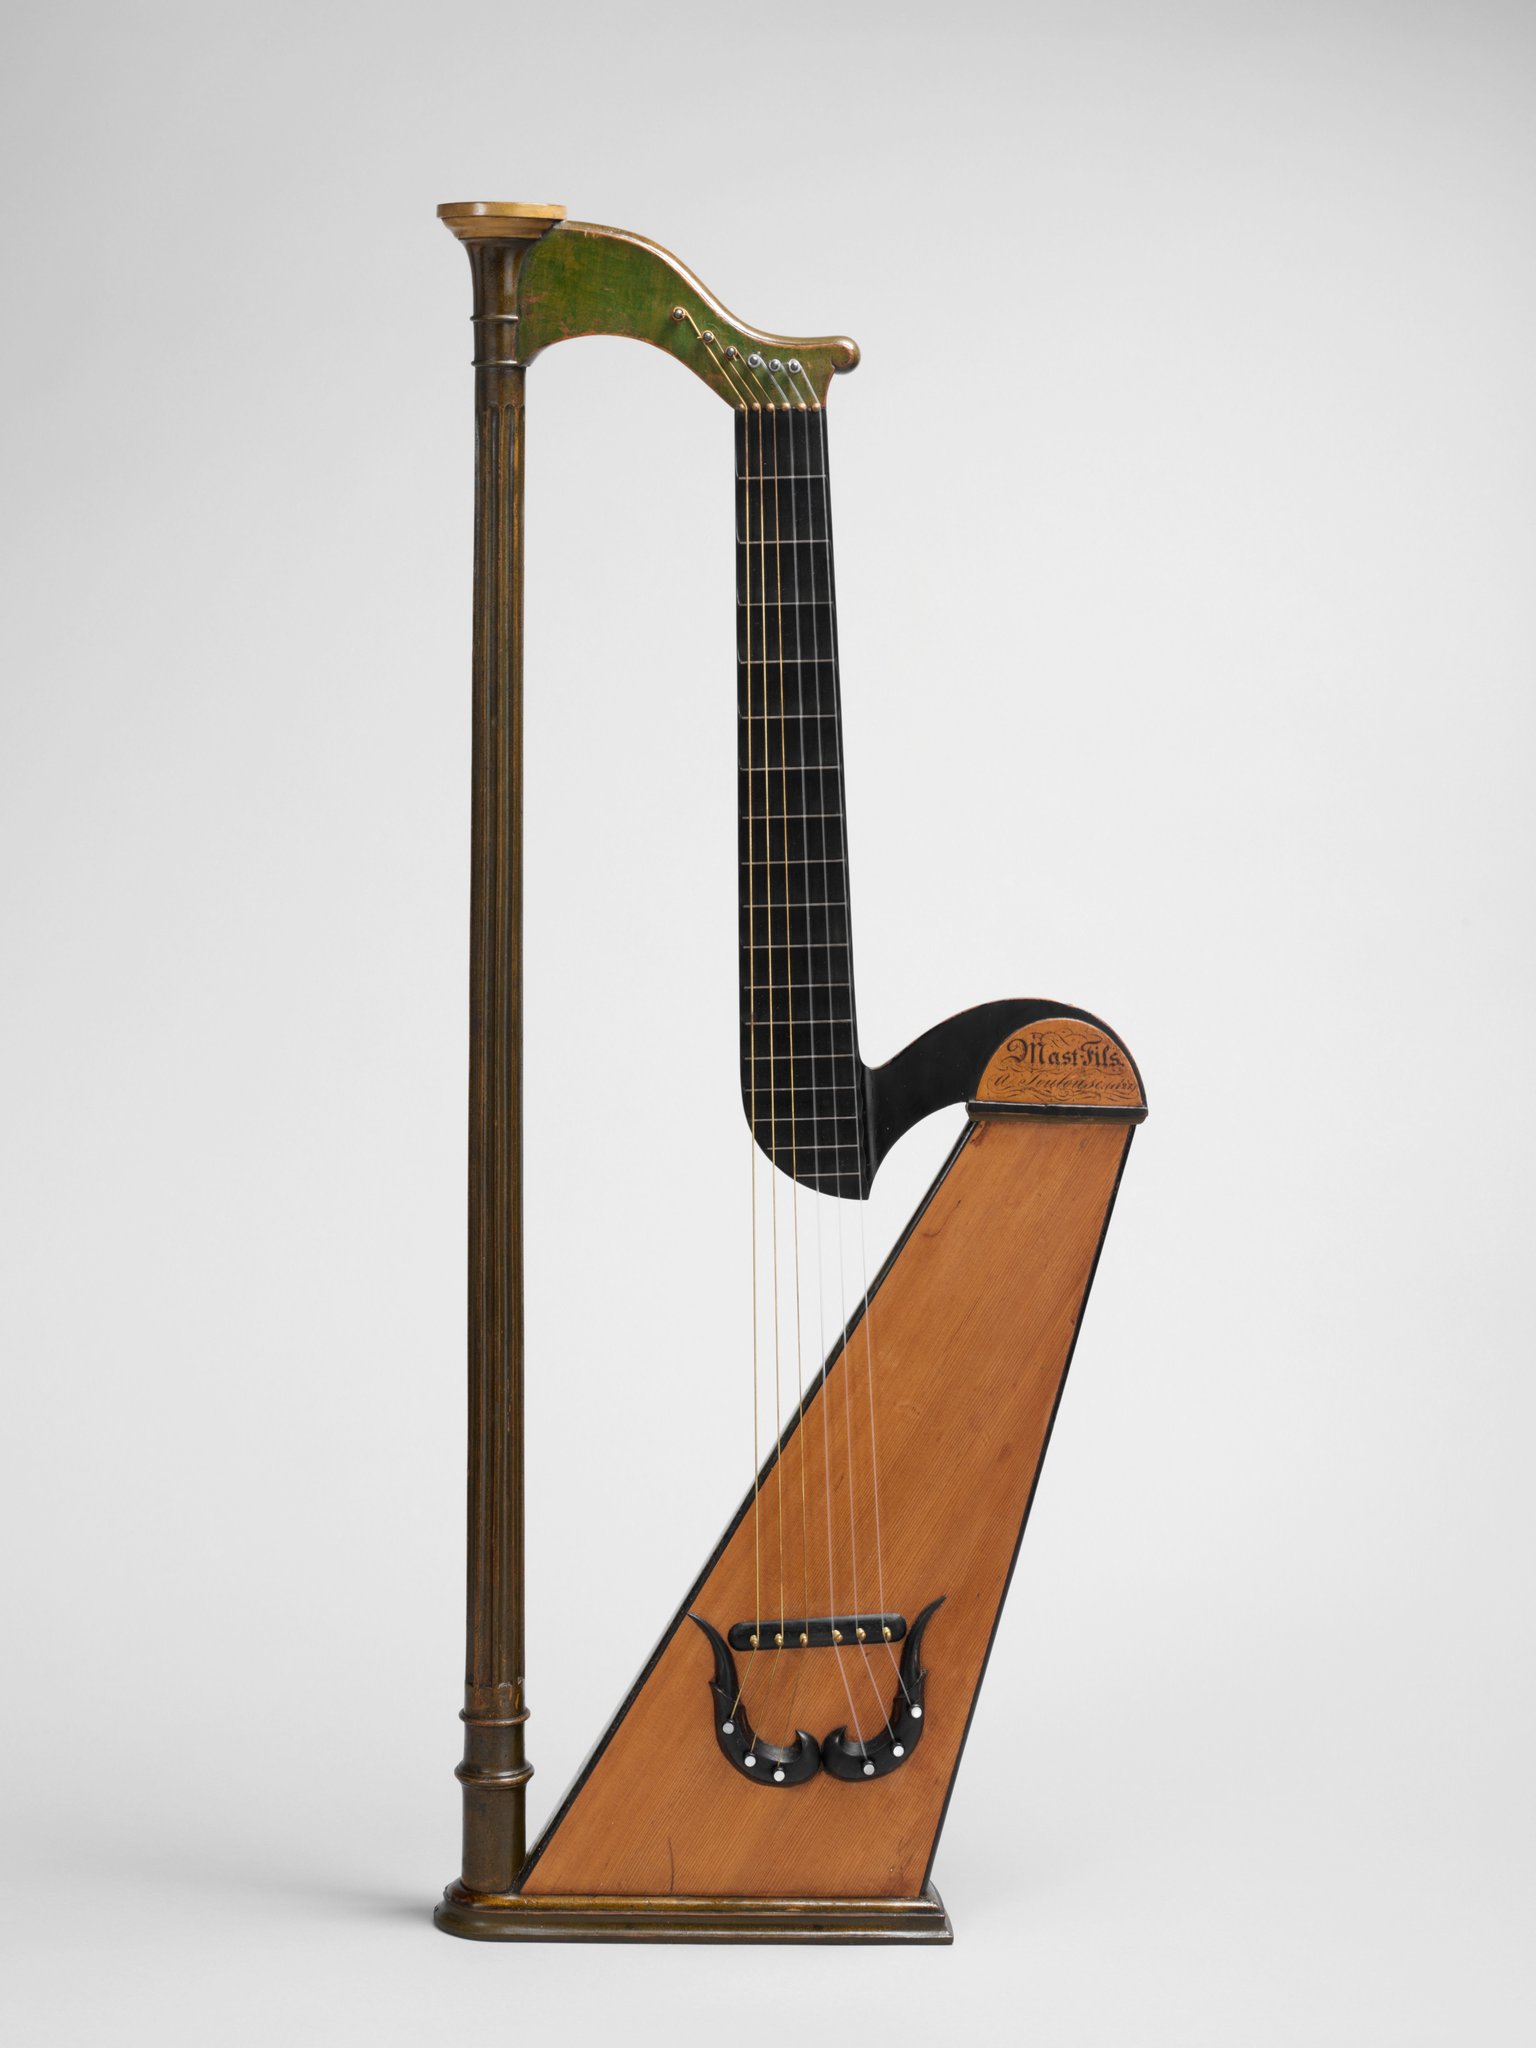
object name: harp guitar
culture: french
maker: joseph laurent mast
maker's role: maker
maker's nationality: french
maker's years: 1779-1830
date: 1827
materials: iron, wood, nickel, silver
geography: france